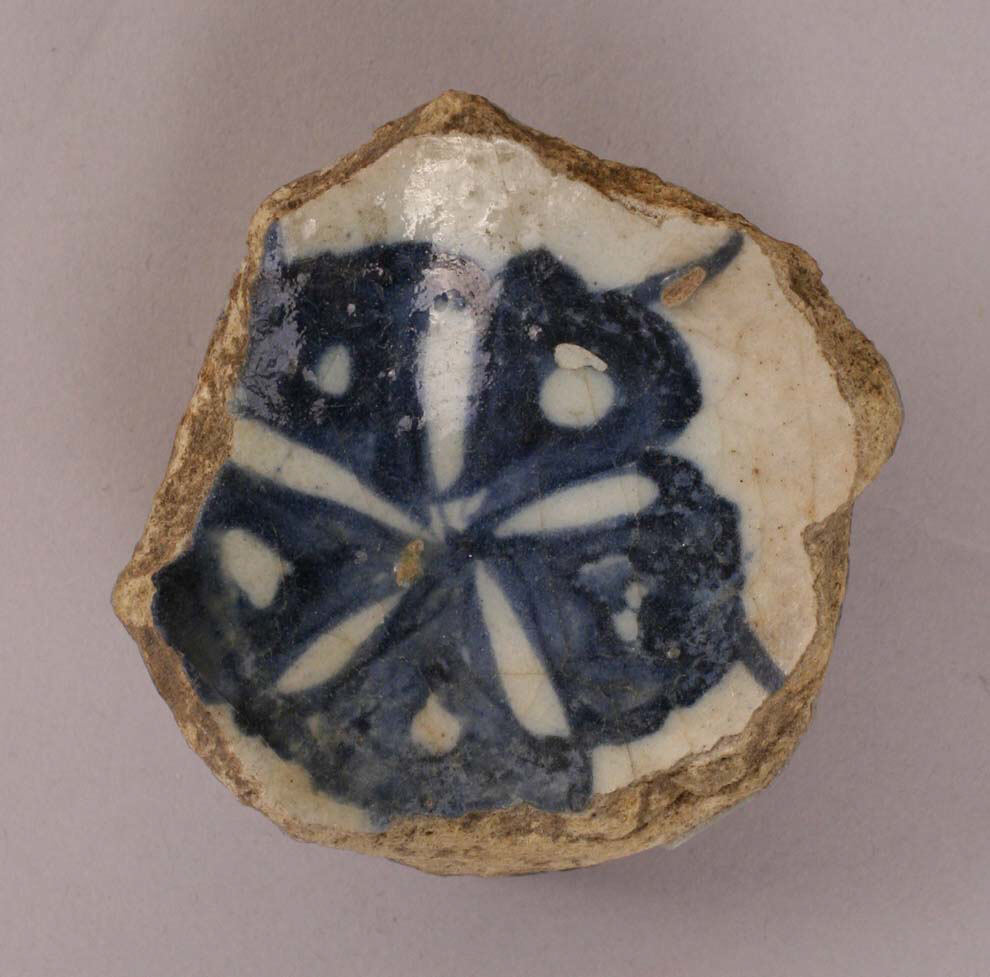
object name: fragment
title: Fragment of a Bowl or Cup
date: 1201-1600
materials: glaze, stonepaste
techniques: painting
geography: egypt